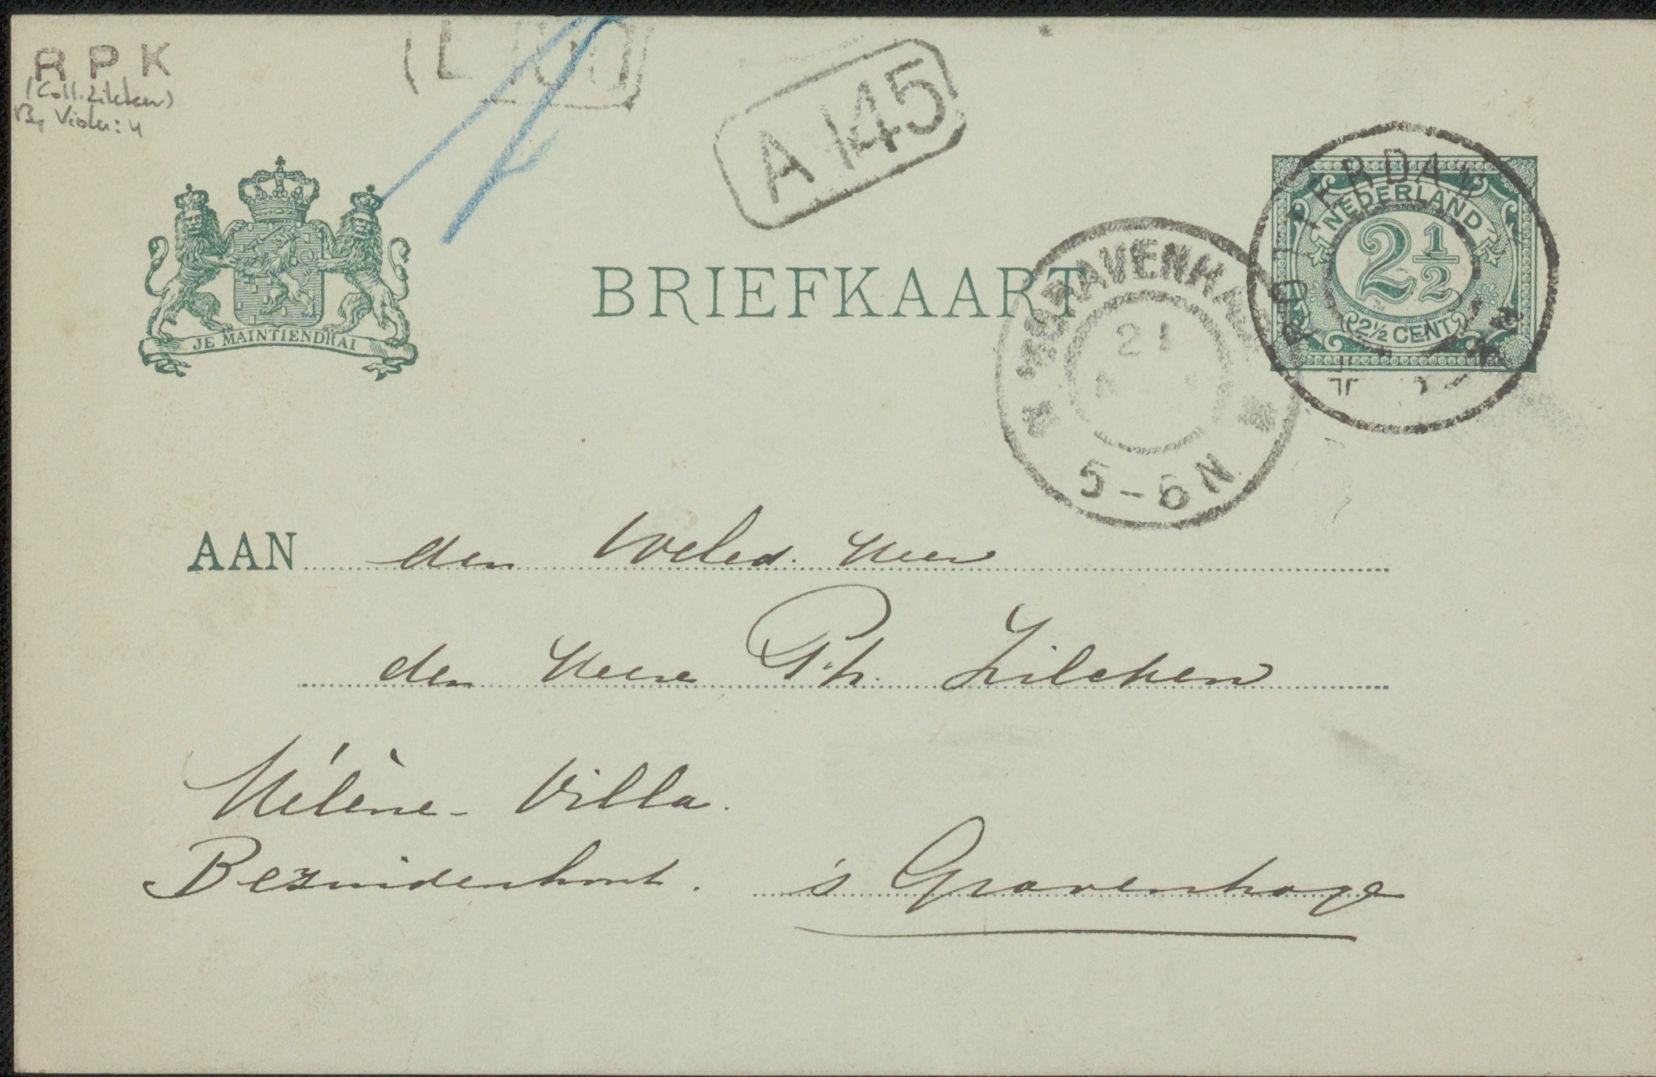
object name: postcard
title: Briefkaart aan Philip Zilcken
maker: maria viola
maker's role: dichter, kunstcriticus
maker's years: 1871-1951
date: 1903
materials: cardboard, ink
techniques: pen, writing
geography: rotterdam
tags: painter, draughtsman, jozef israëls, philip zilcken, photography, cinematography, painting (including book-illumination, miniature-painting)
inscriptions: collector's mark: ‘RPK’